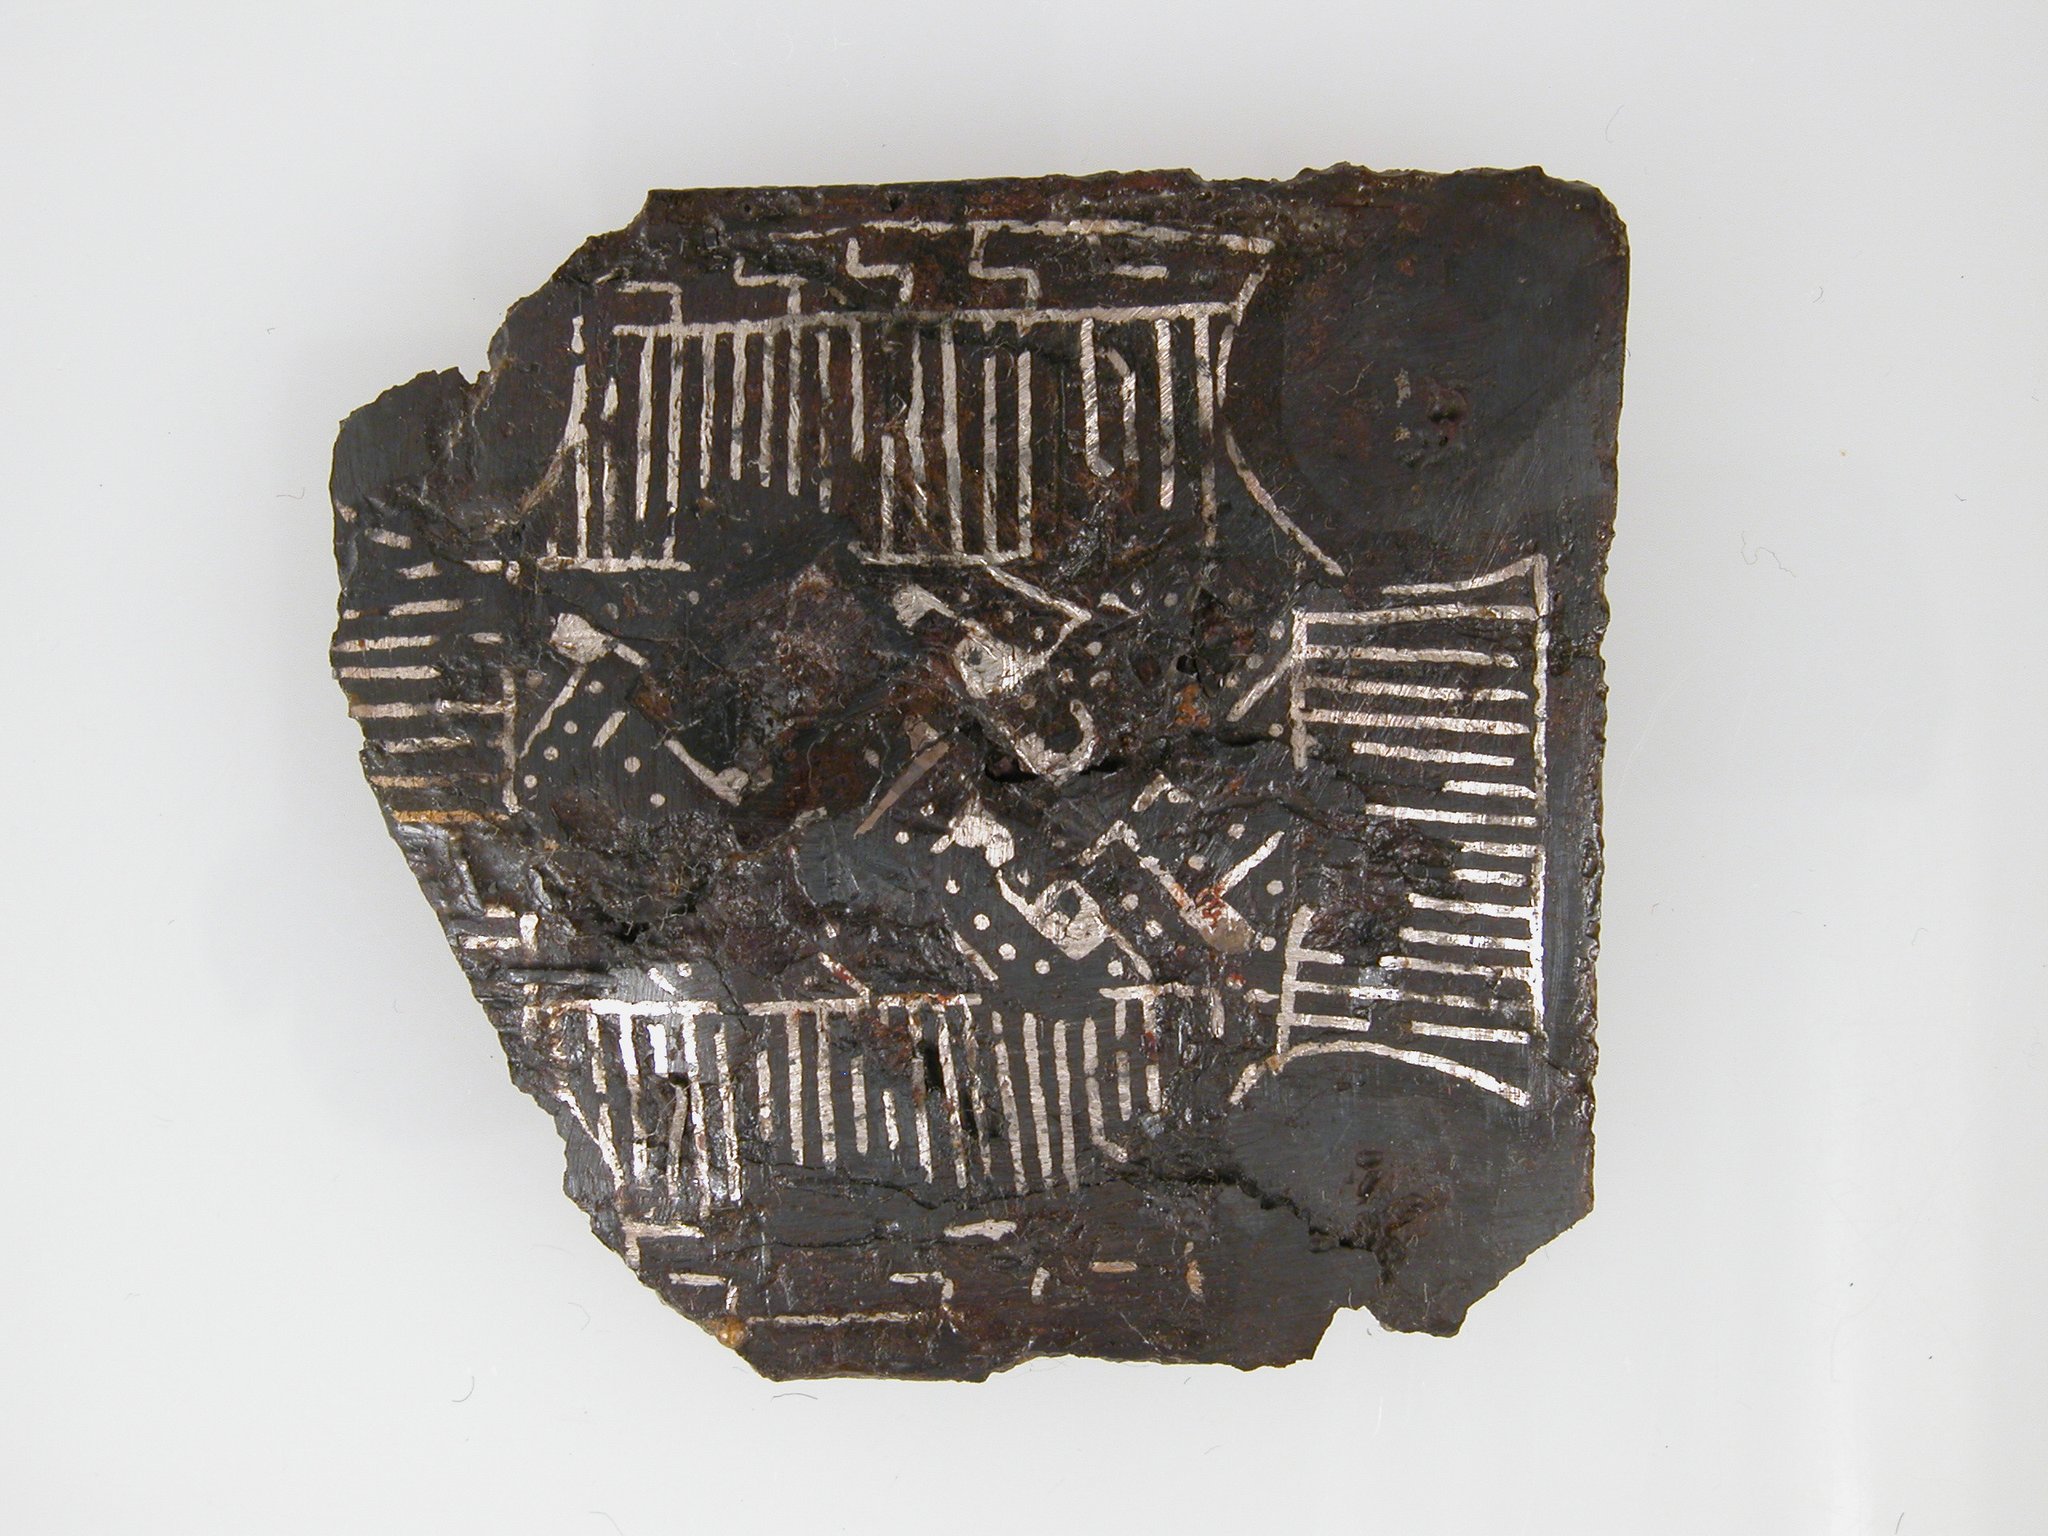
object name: buckle plate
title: Belt Plate Fragment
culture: frankish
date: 301-700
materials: iron, silver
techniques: inlay